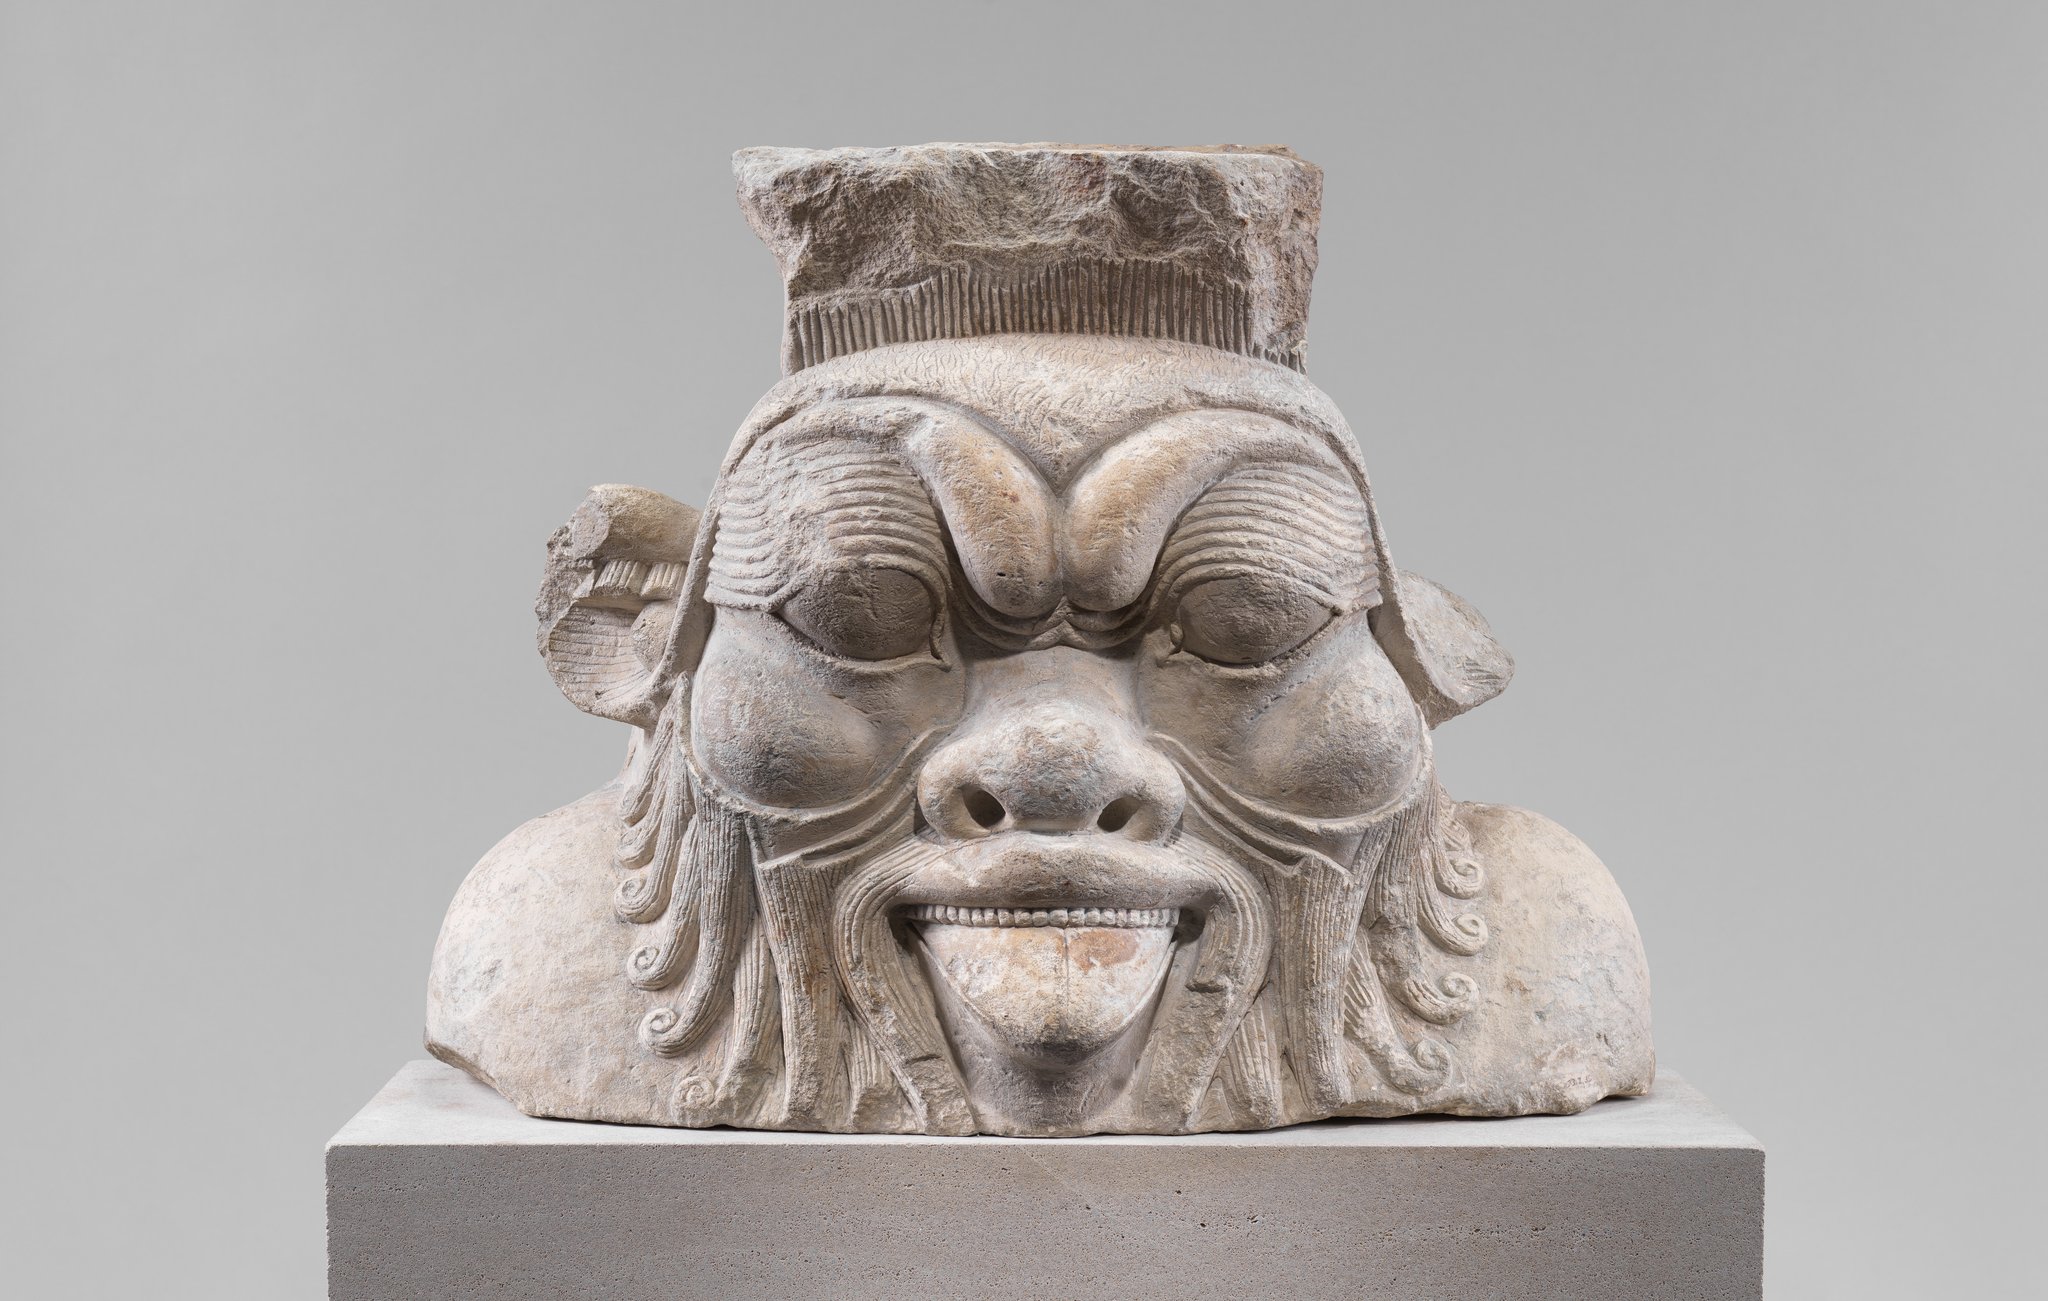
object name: column capital, be image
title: Colossal head from a Bes-image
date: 332-330 BCE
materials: limestone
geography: eastern delta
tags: bes